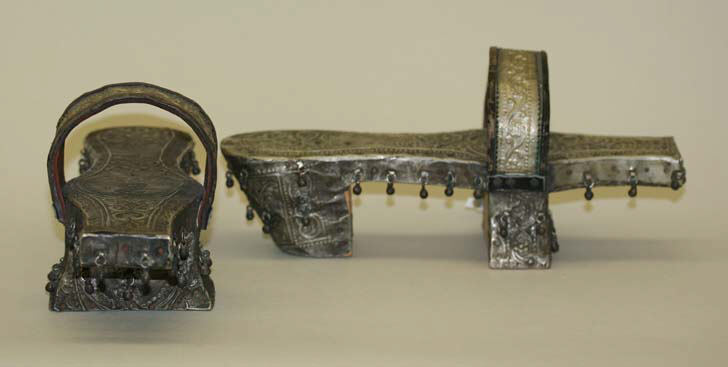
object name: shoe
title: Hammam Shoes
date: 1801-1900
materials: leather, silver, wood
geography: turkey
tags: footwear